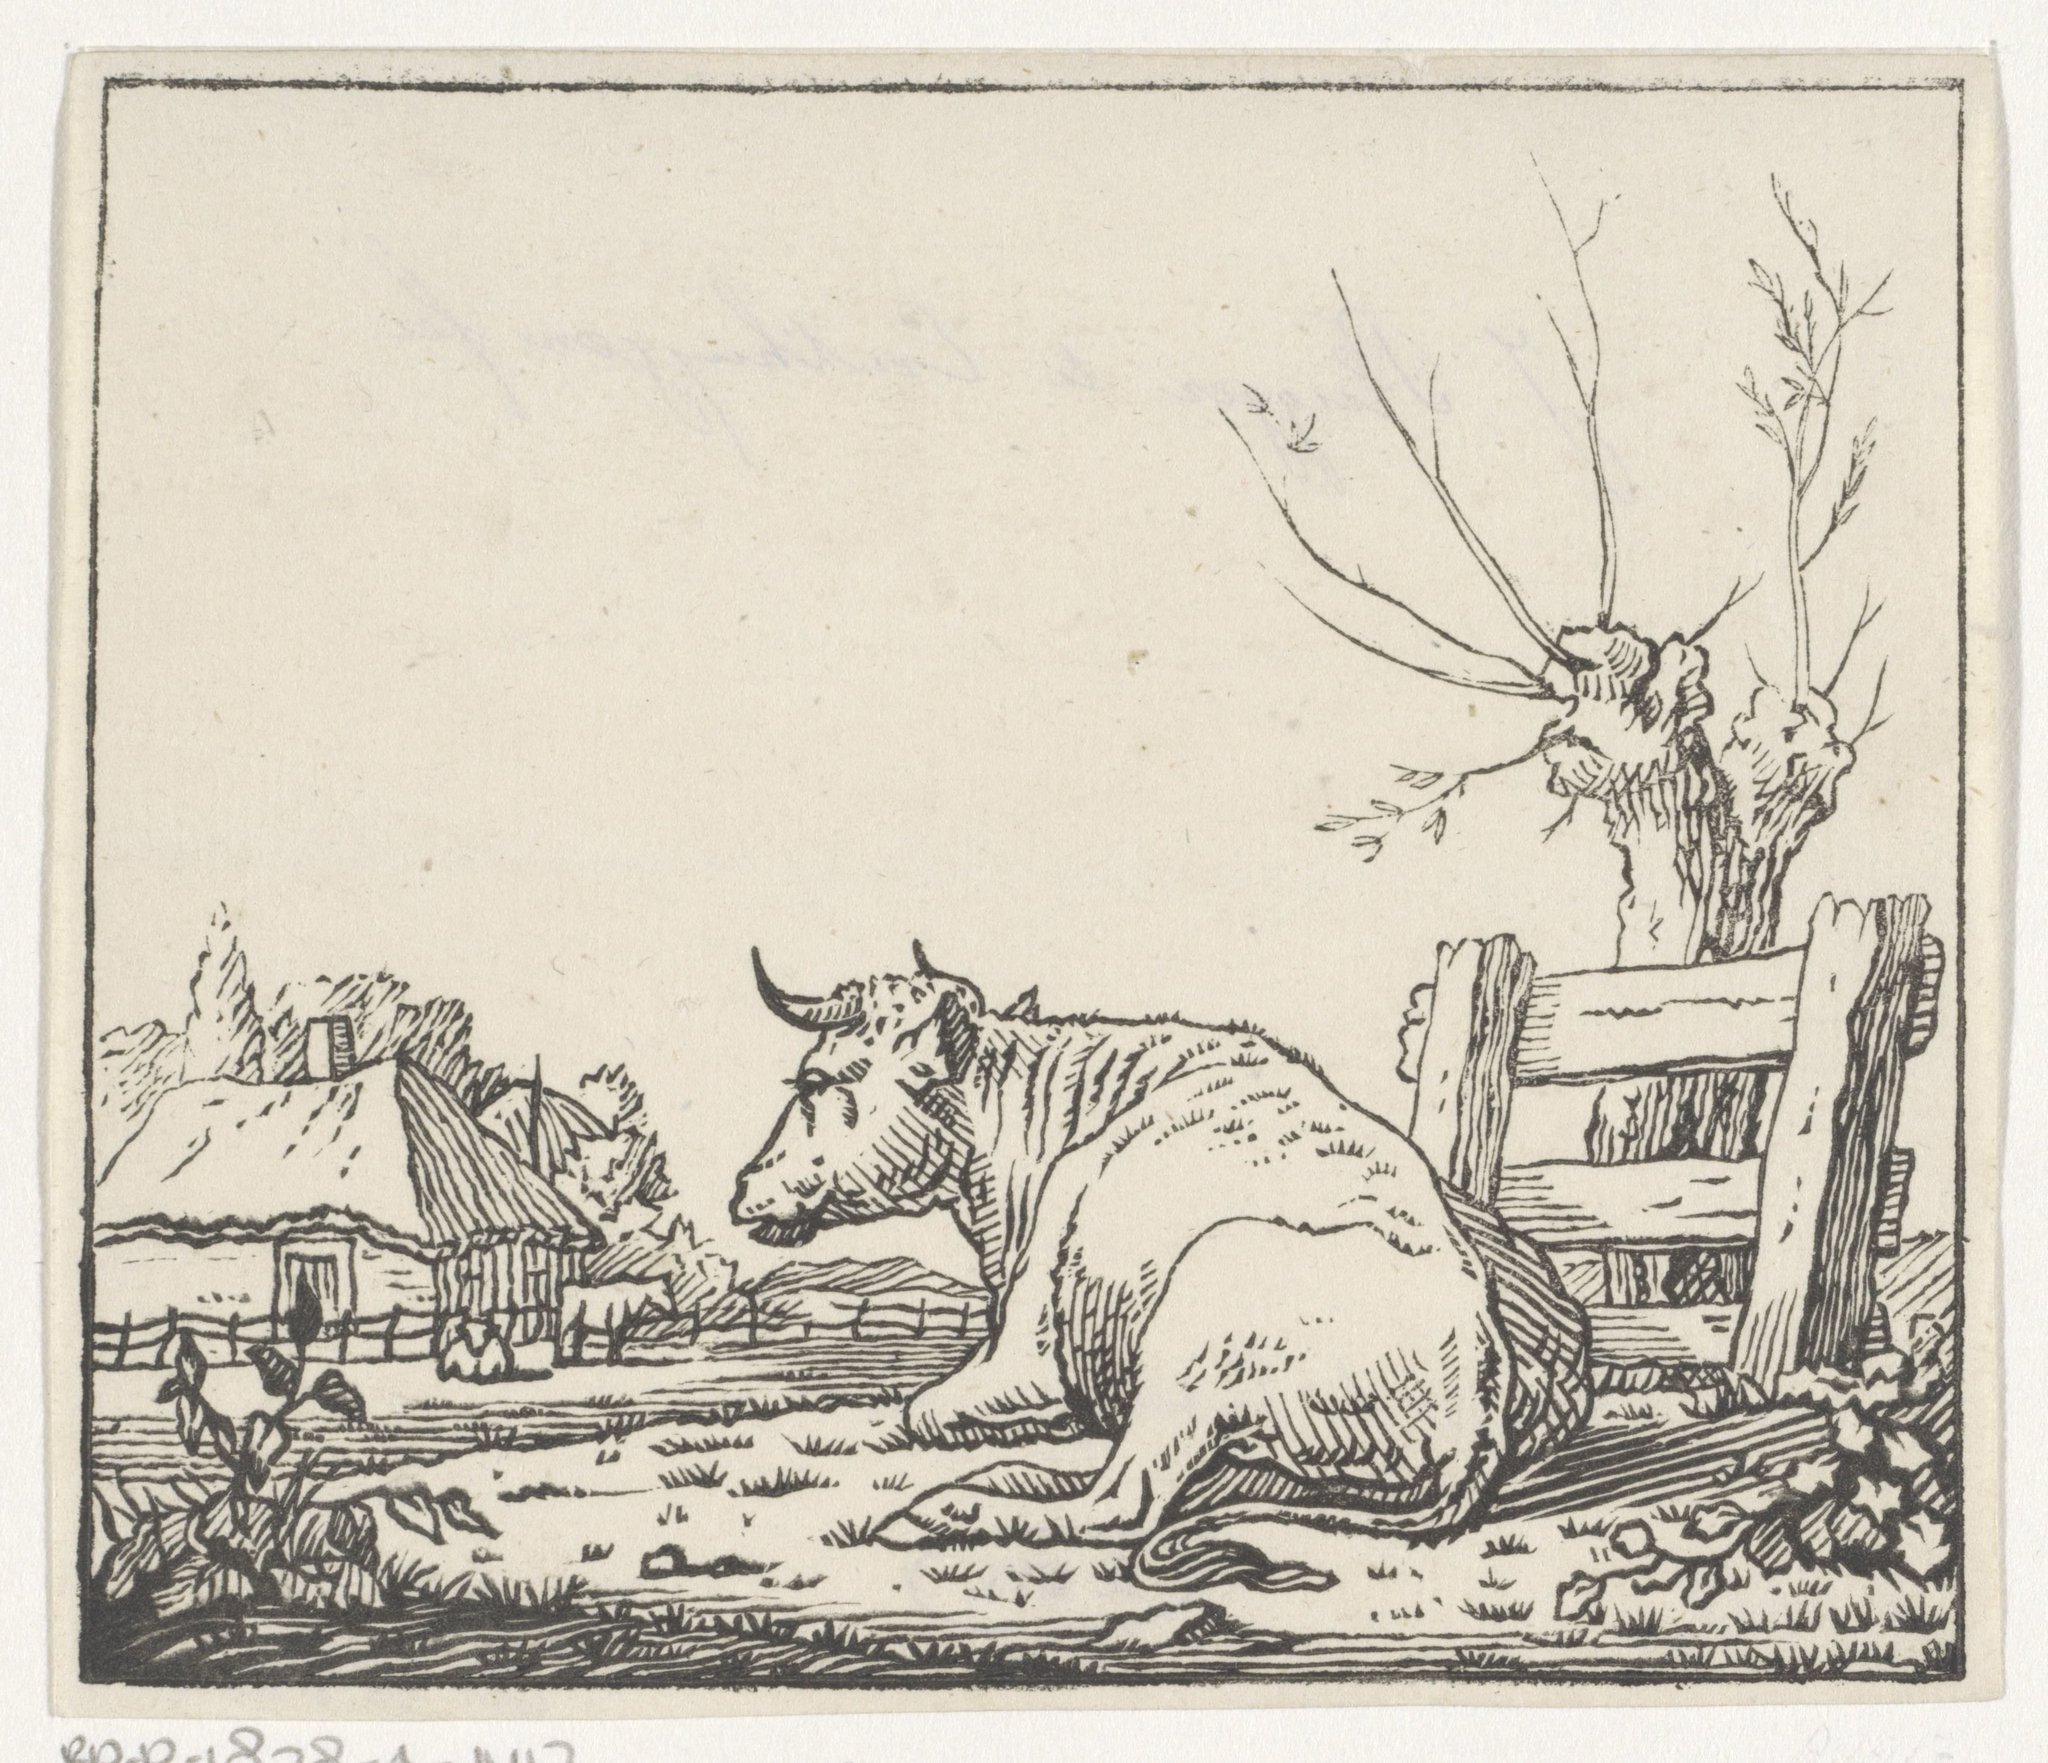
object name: print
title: Koe liggend naast een knotwilg in de wei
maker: jacob plügger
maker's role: print maker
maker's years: 1795-1871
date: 1805-1871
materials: paper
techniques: woodcut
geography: netherlands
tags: cow, meadow, pasture, trees: willow, farm or solitary house in landscape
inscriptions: collector's mark: Lugt 2228